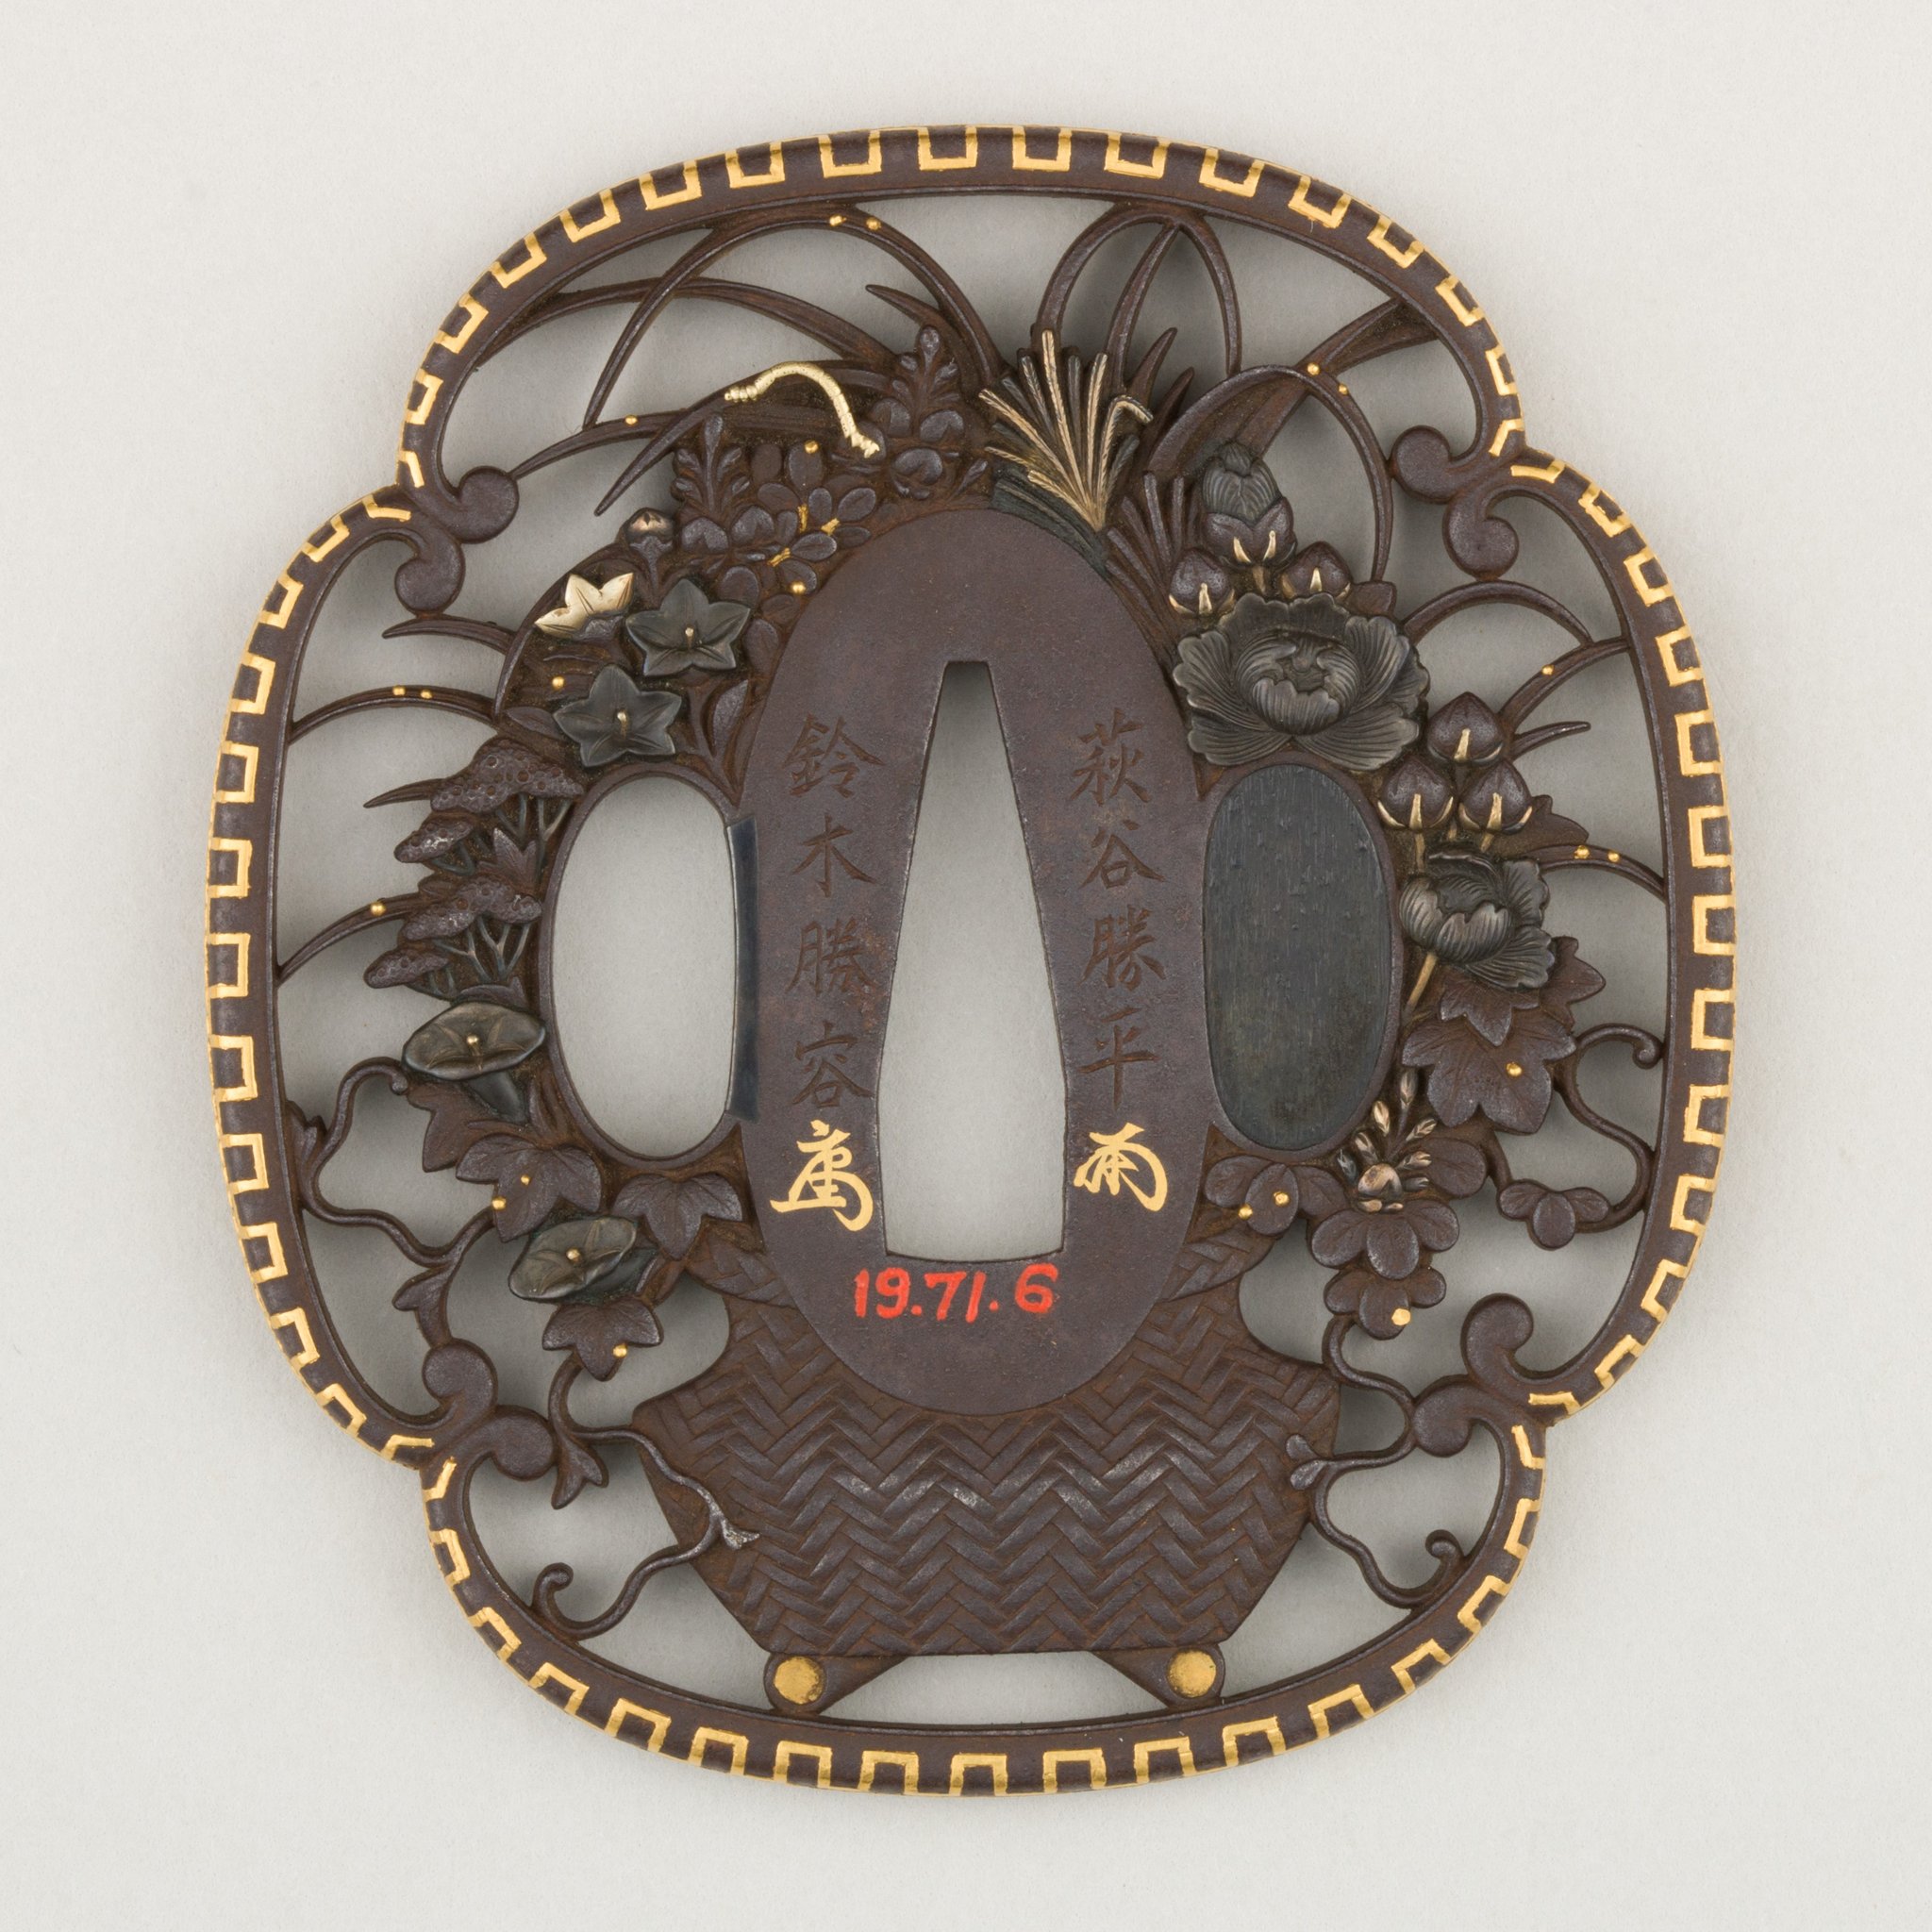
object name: sword guard tsuba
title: Sword guard (Tsuba) With Flower Basket Motif (花籠透鐔)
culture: japanese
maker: 萩谷勝平 hagiya katsuhira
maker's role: fittings maker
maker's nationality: japanese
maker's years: 1804-1886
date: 1860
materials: copper, silver alloy, gold, iron, silver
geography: japan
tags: flowers